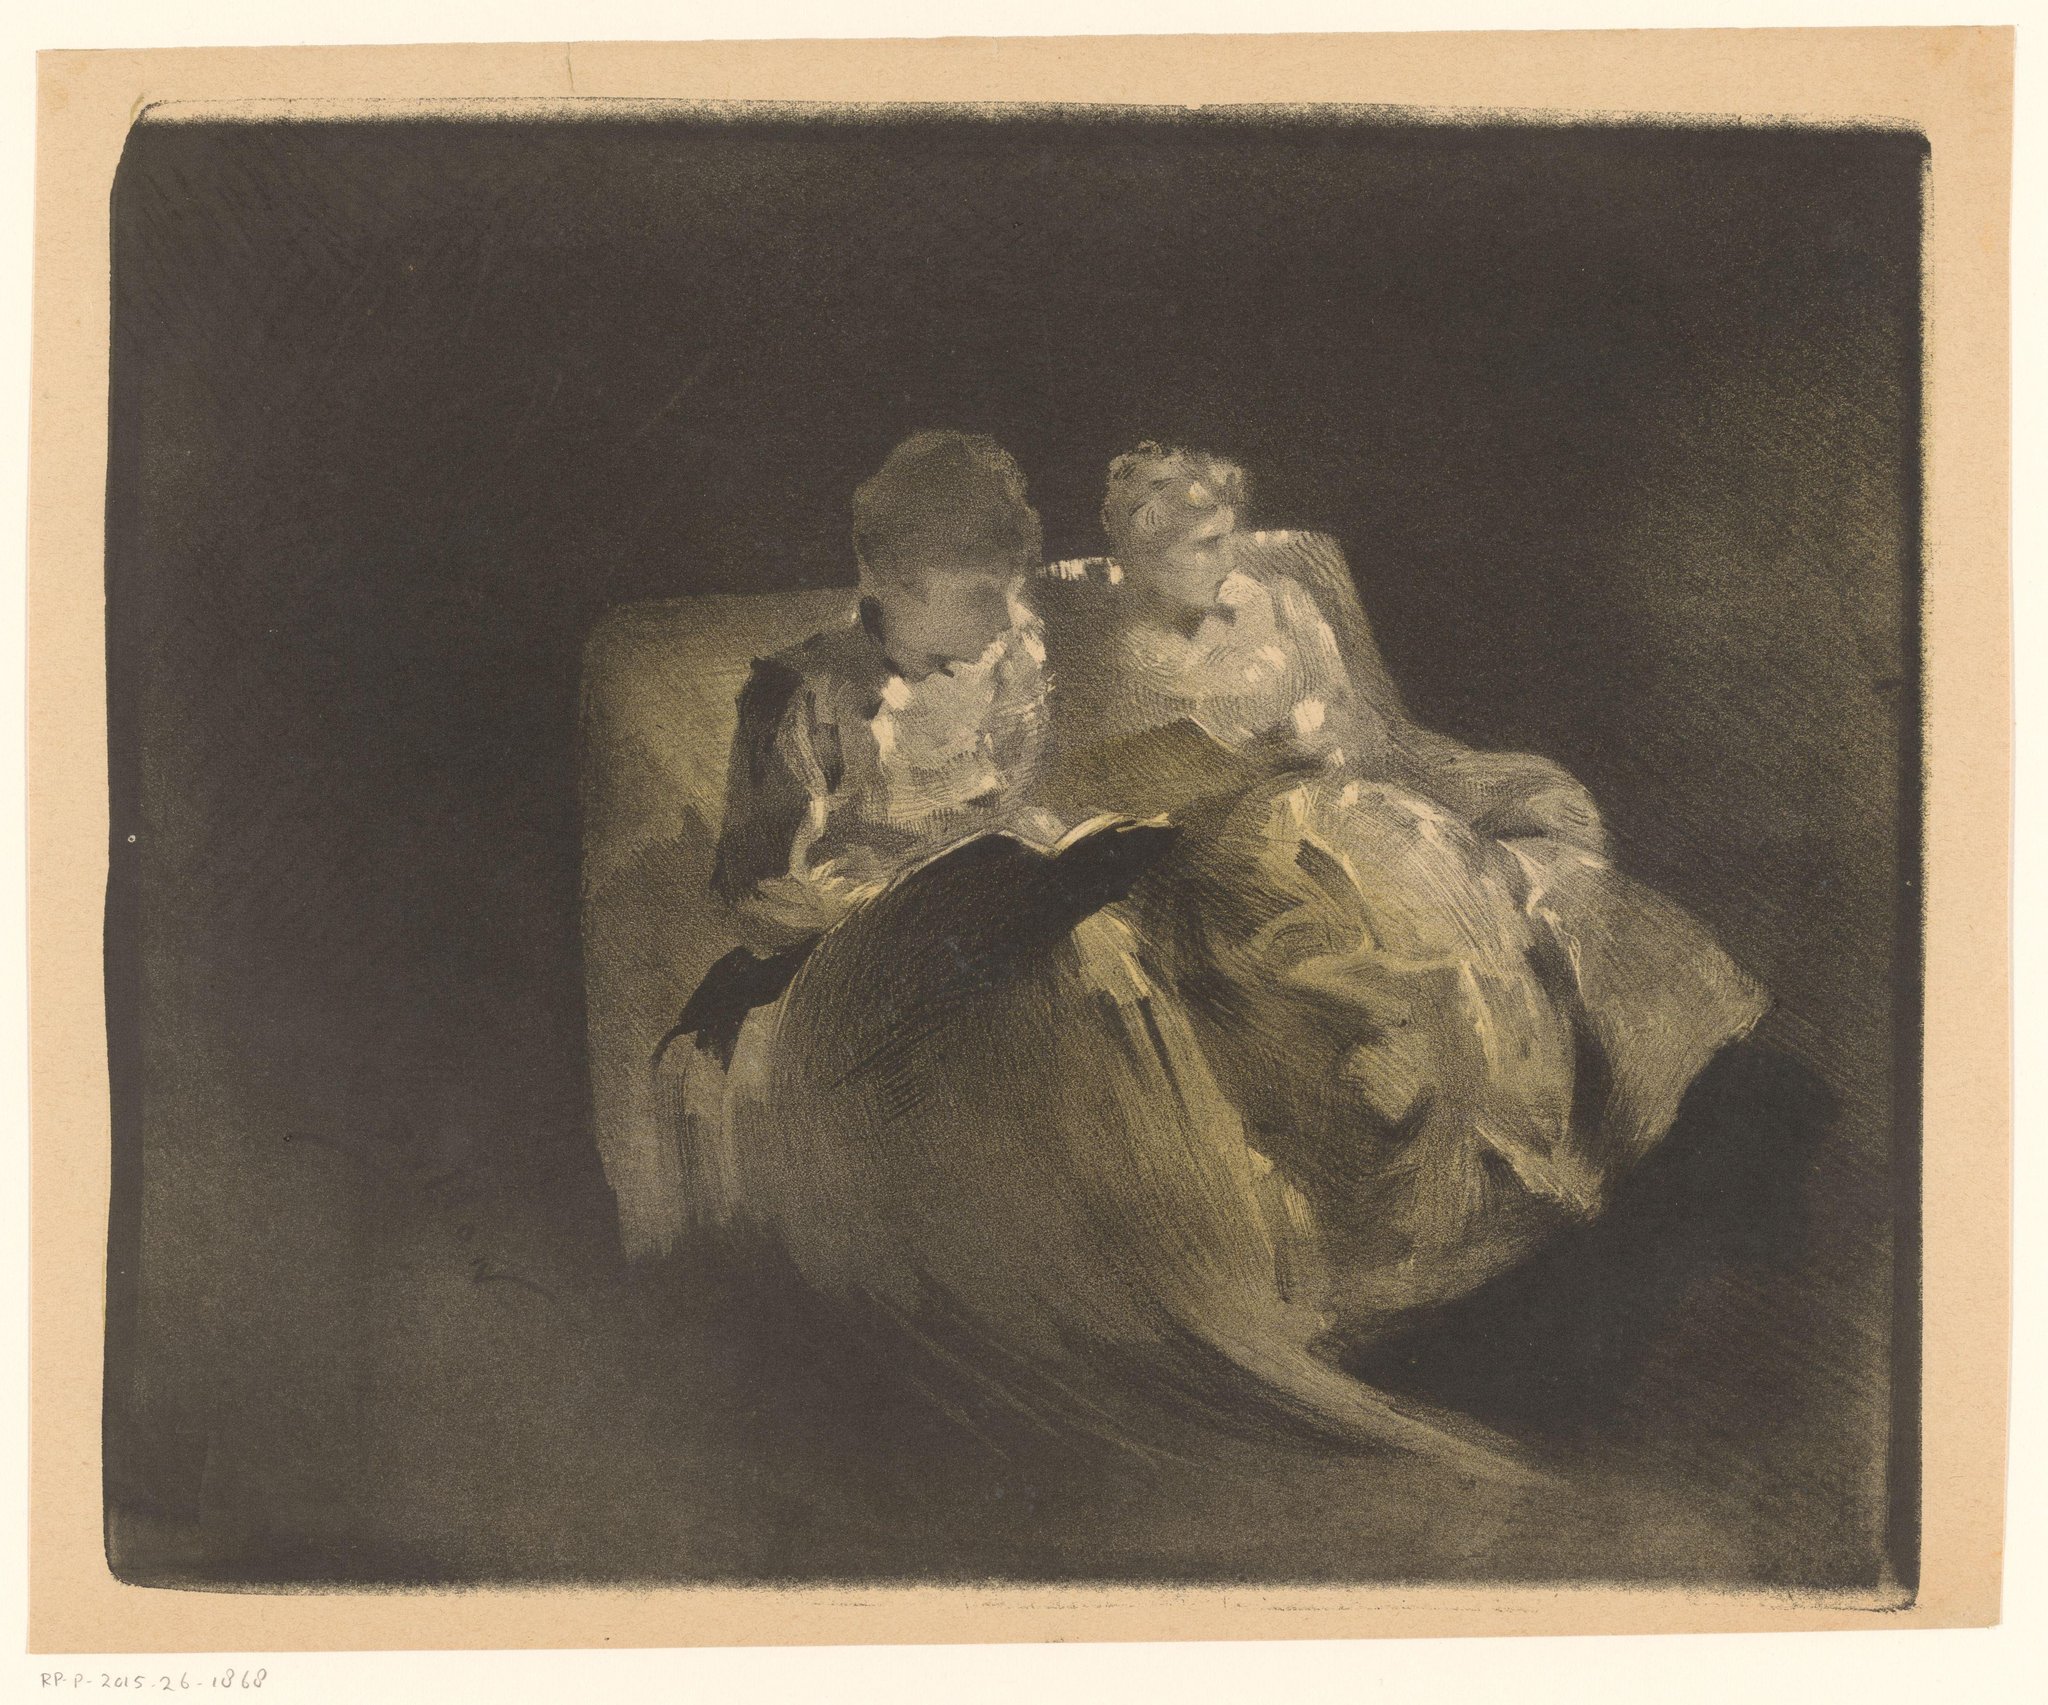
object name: print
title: Twee lezende vrouwen op een bank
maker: henri patrice dillon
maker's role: print maker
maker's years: 1850-1909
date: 1860-1909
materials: paper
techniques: lithograph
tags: reading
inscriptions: collector's mark: Lugt 2228